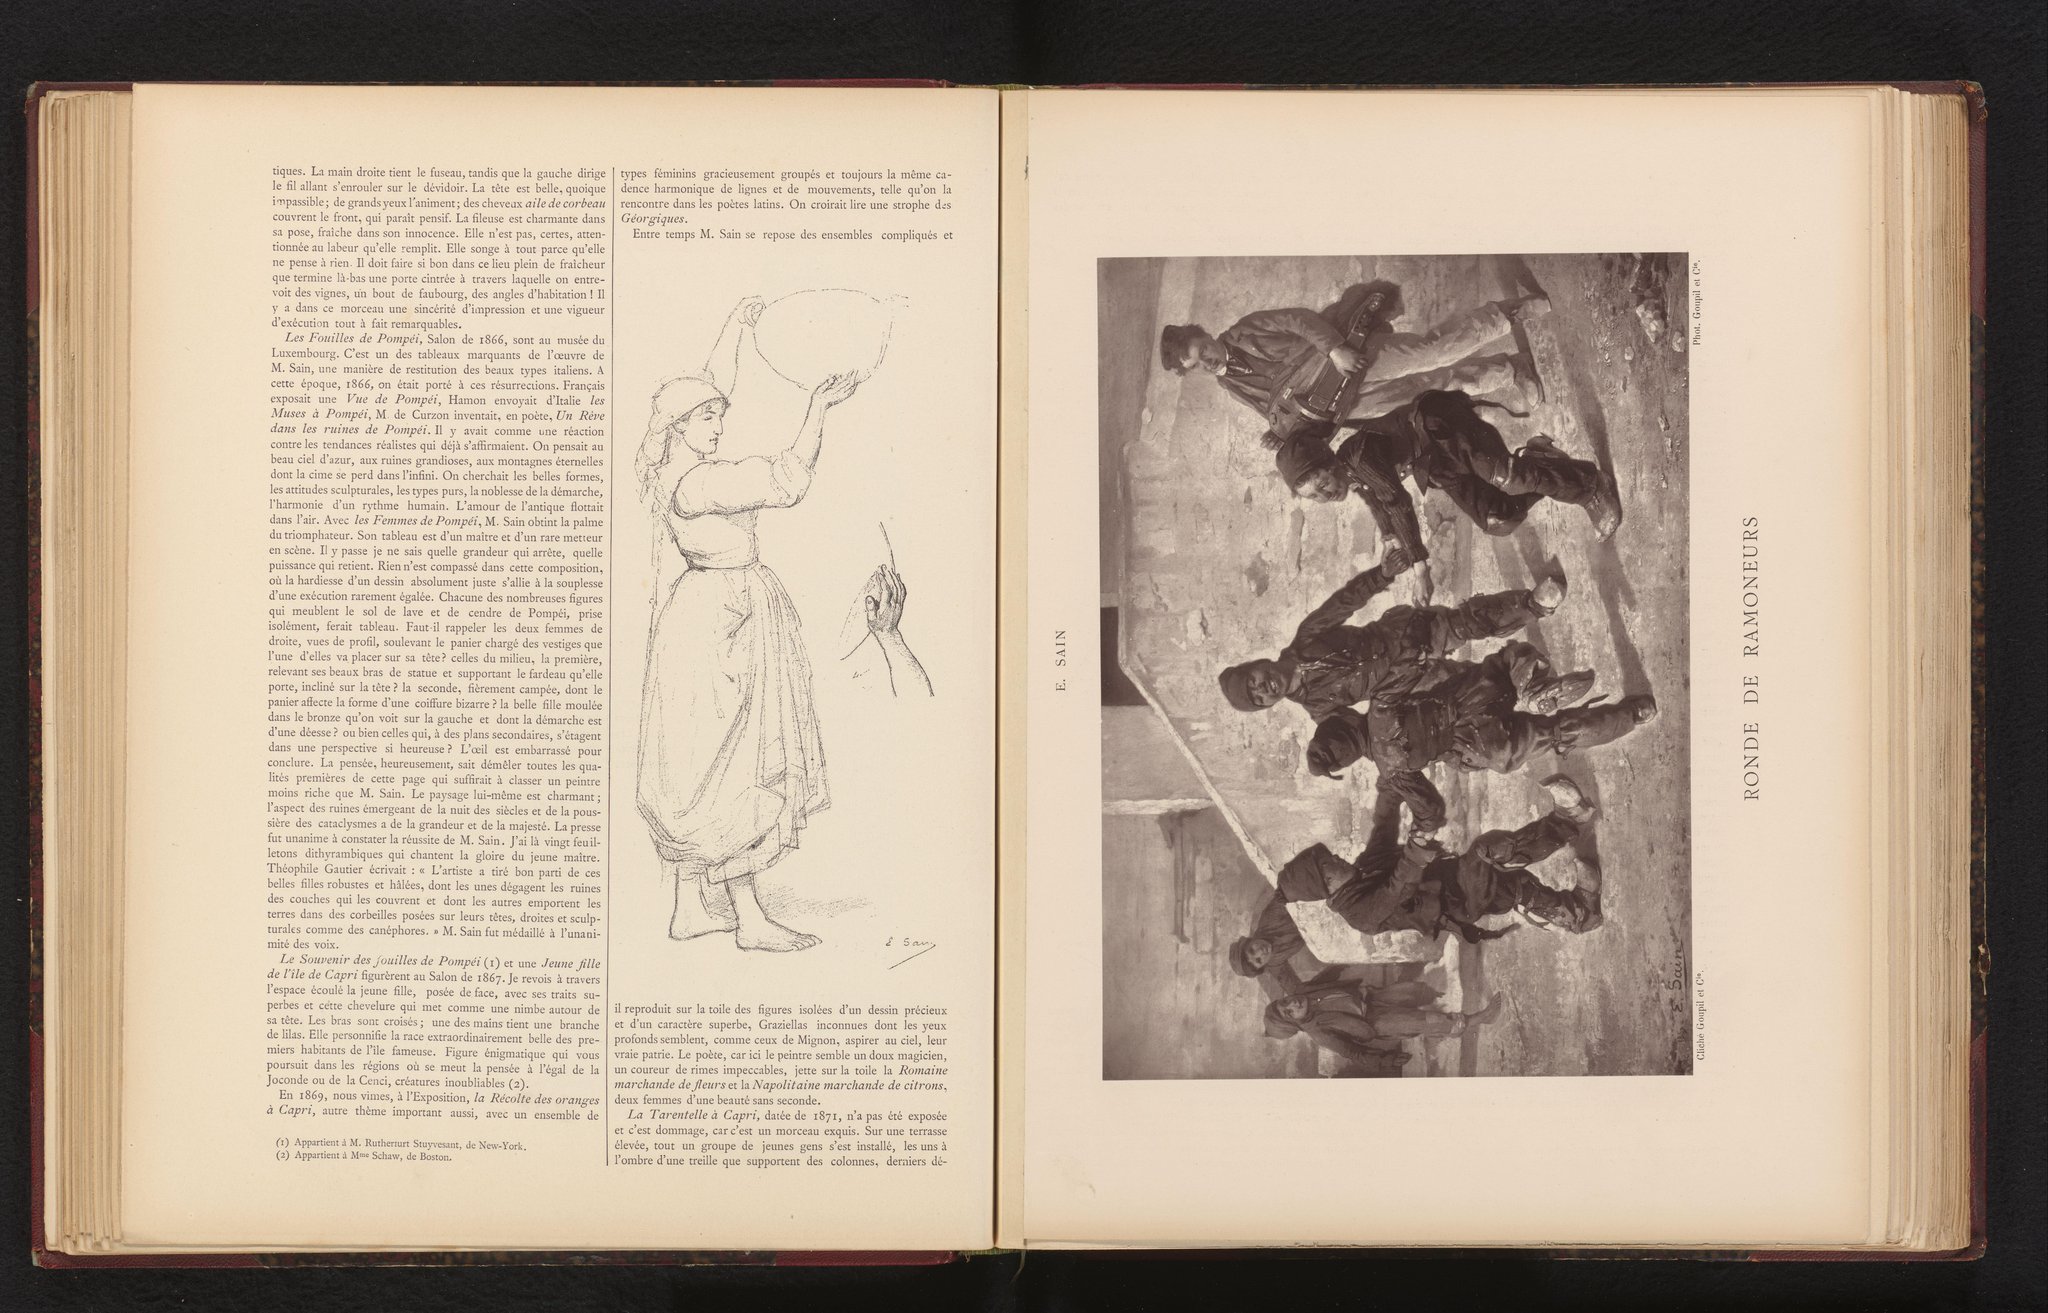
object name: reproduction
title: Ronde de ramoneurs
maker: édouard alexandre sain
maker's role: painter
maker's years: 1830-1910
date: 1878-1883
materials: paper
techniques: woodburytype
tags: dancing games (children's games)